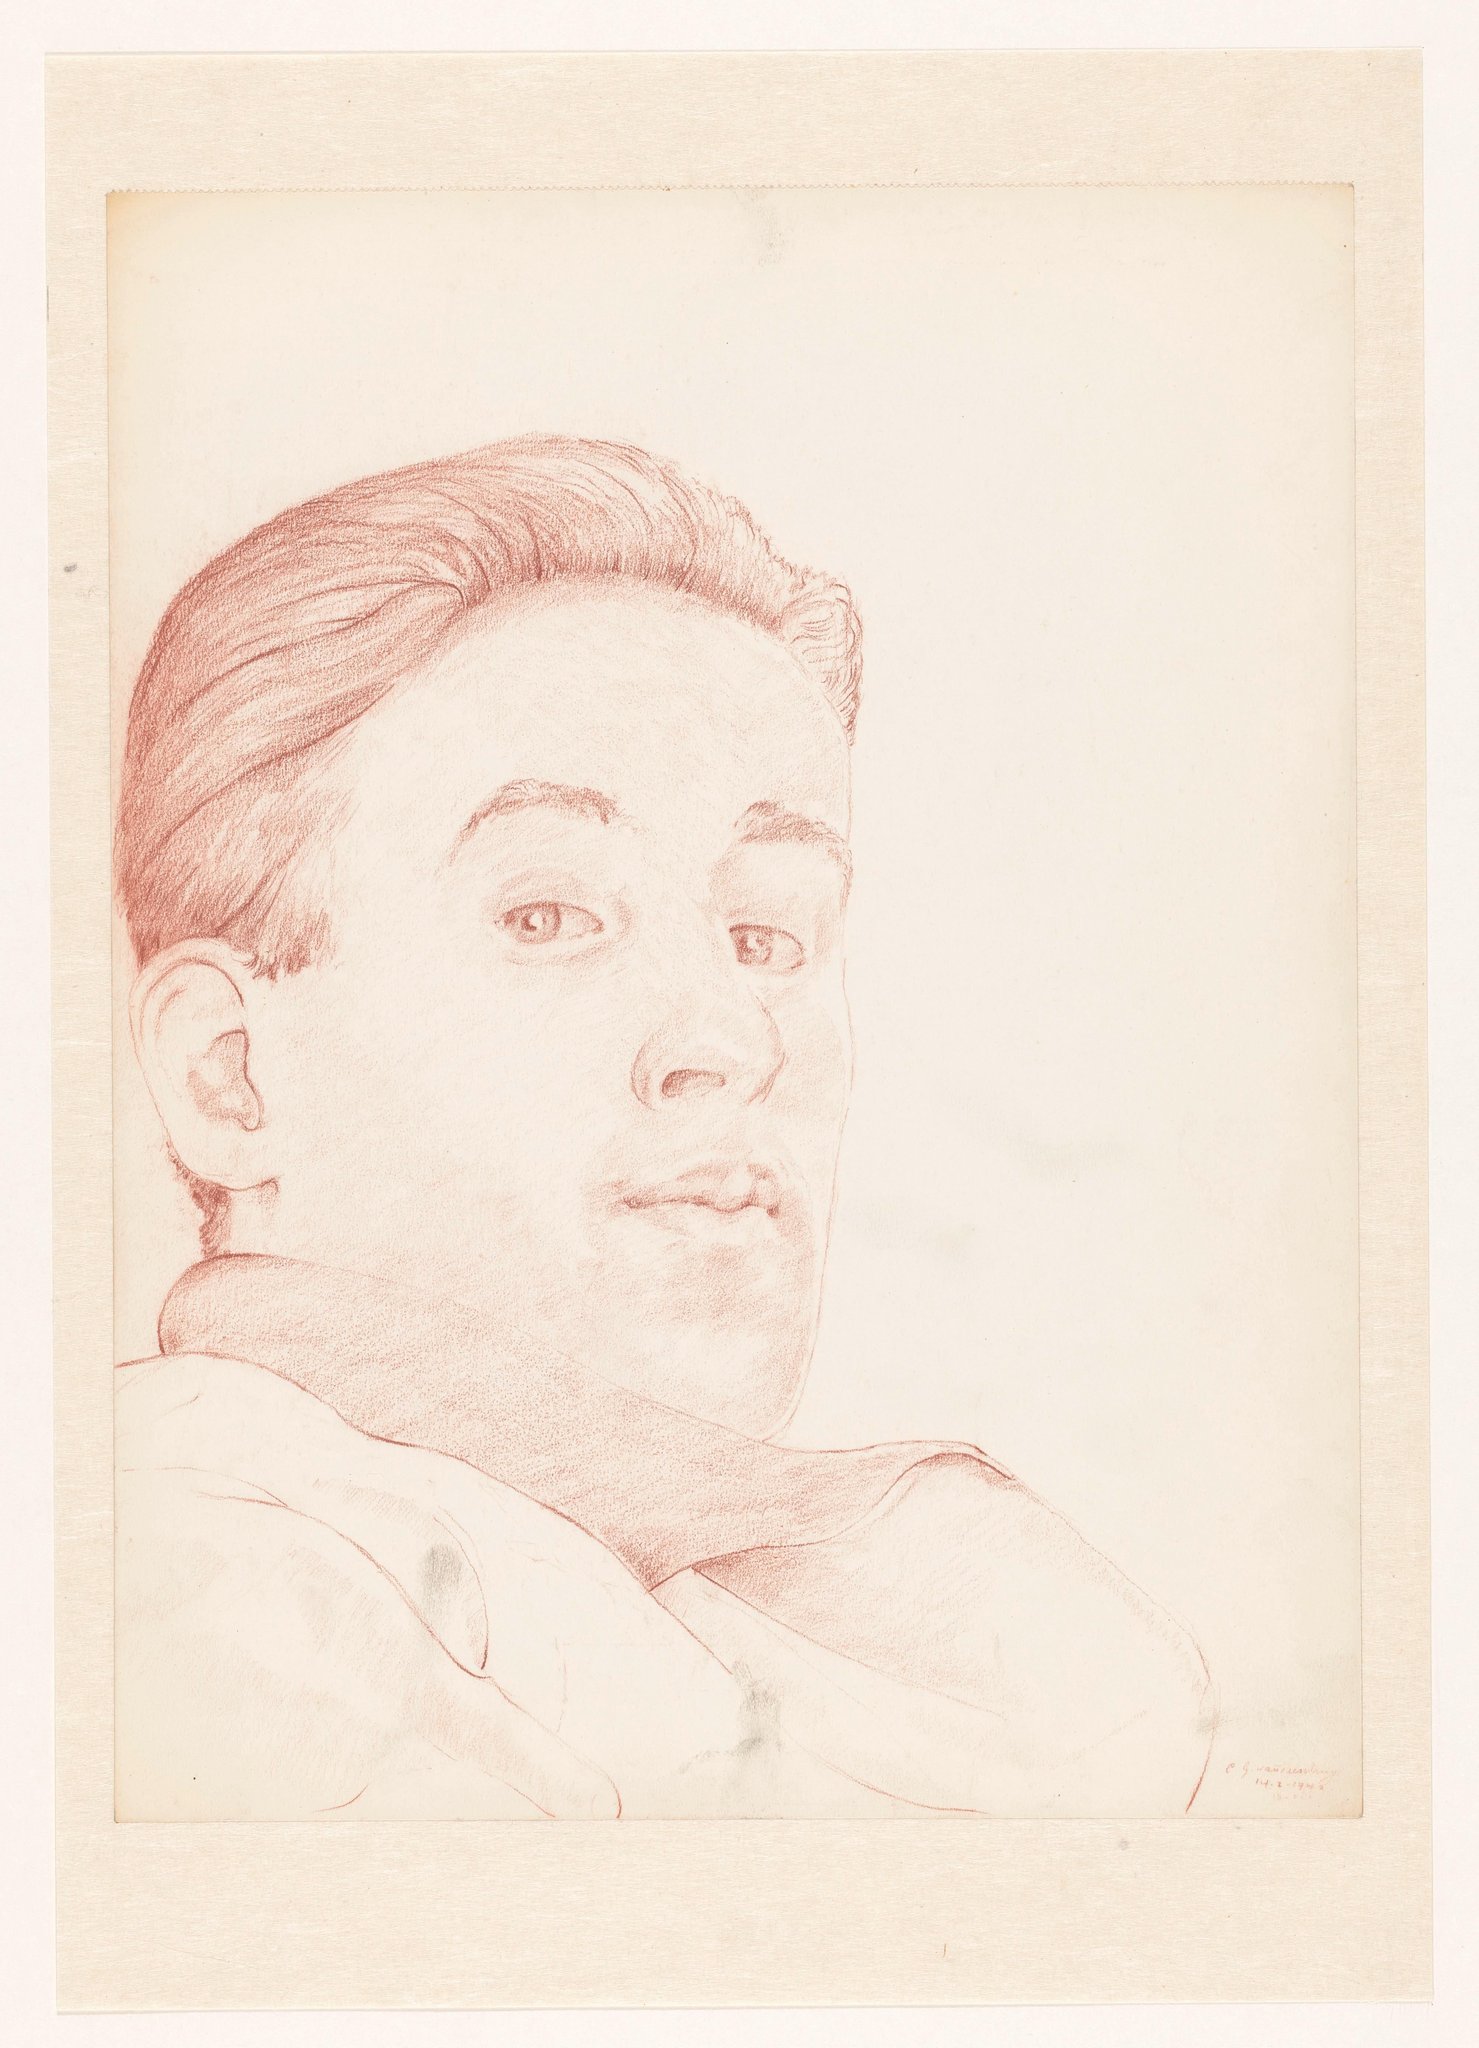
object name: drawing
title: Zelfportretten van Cor van Teeseling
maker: cor van teeseling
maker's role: draughtsman, sculptor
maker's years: 1915-1942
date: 1942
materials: chalk, paper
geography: weteringschans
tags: amsterdam, draughtsman, sculptor, cor van teeseling, historical persons, prisoner in cell or locked place, portrait, self-portrait of draughtsman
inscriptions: signature and date: ‘C G van Teeseling / 14-2-1942 / B-1-1’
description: Zelfportret van Cor van Teeseling: B-1-1, 14 februari. Getekend zelfportret van Cor van Teeseling driekwart, naar rechts kijkend van onderen gezien.